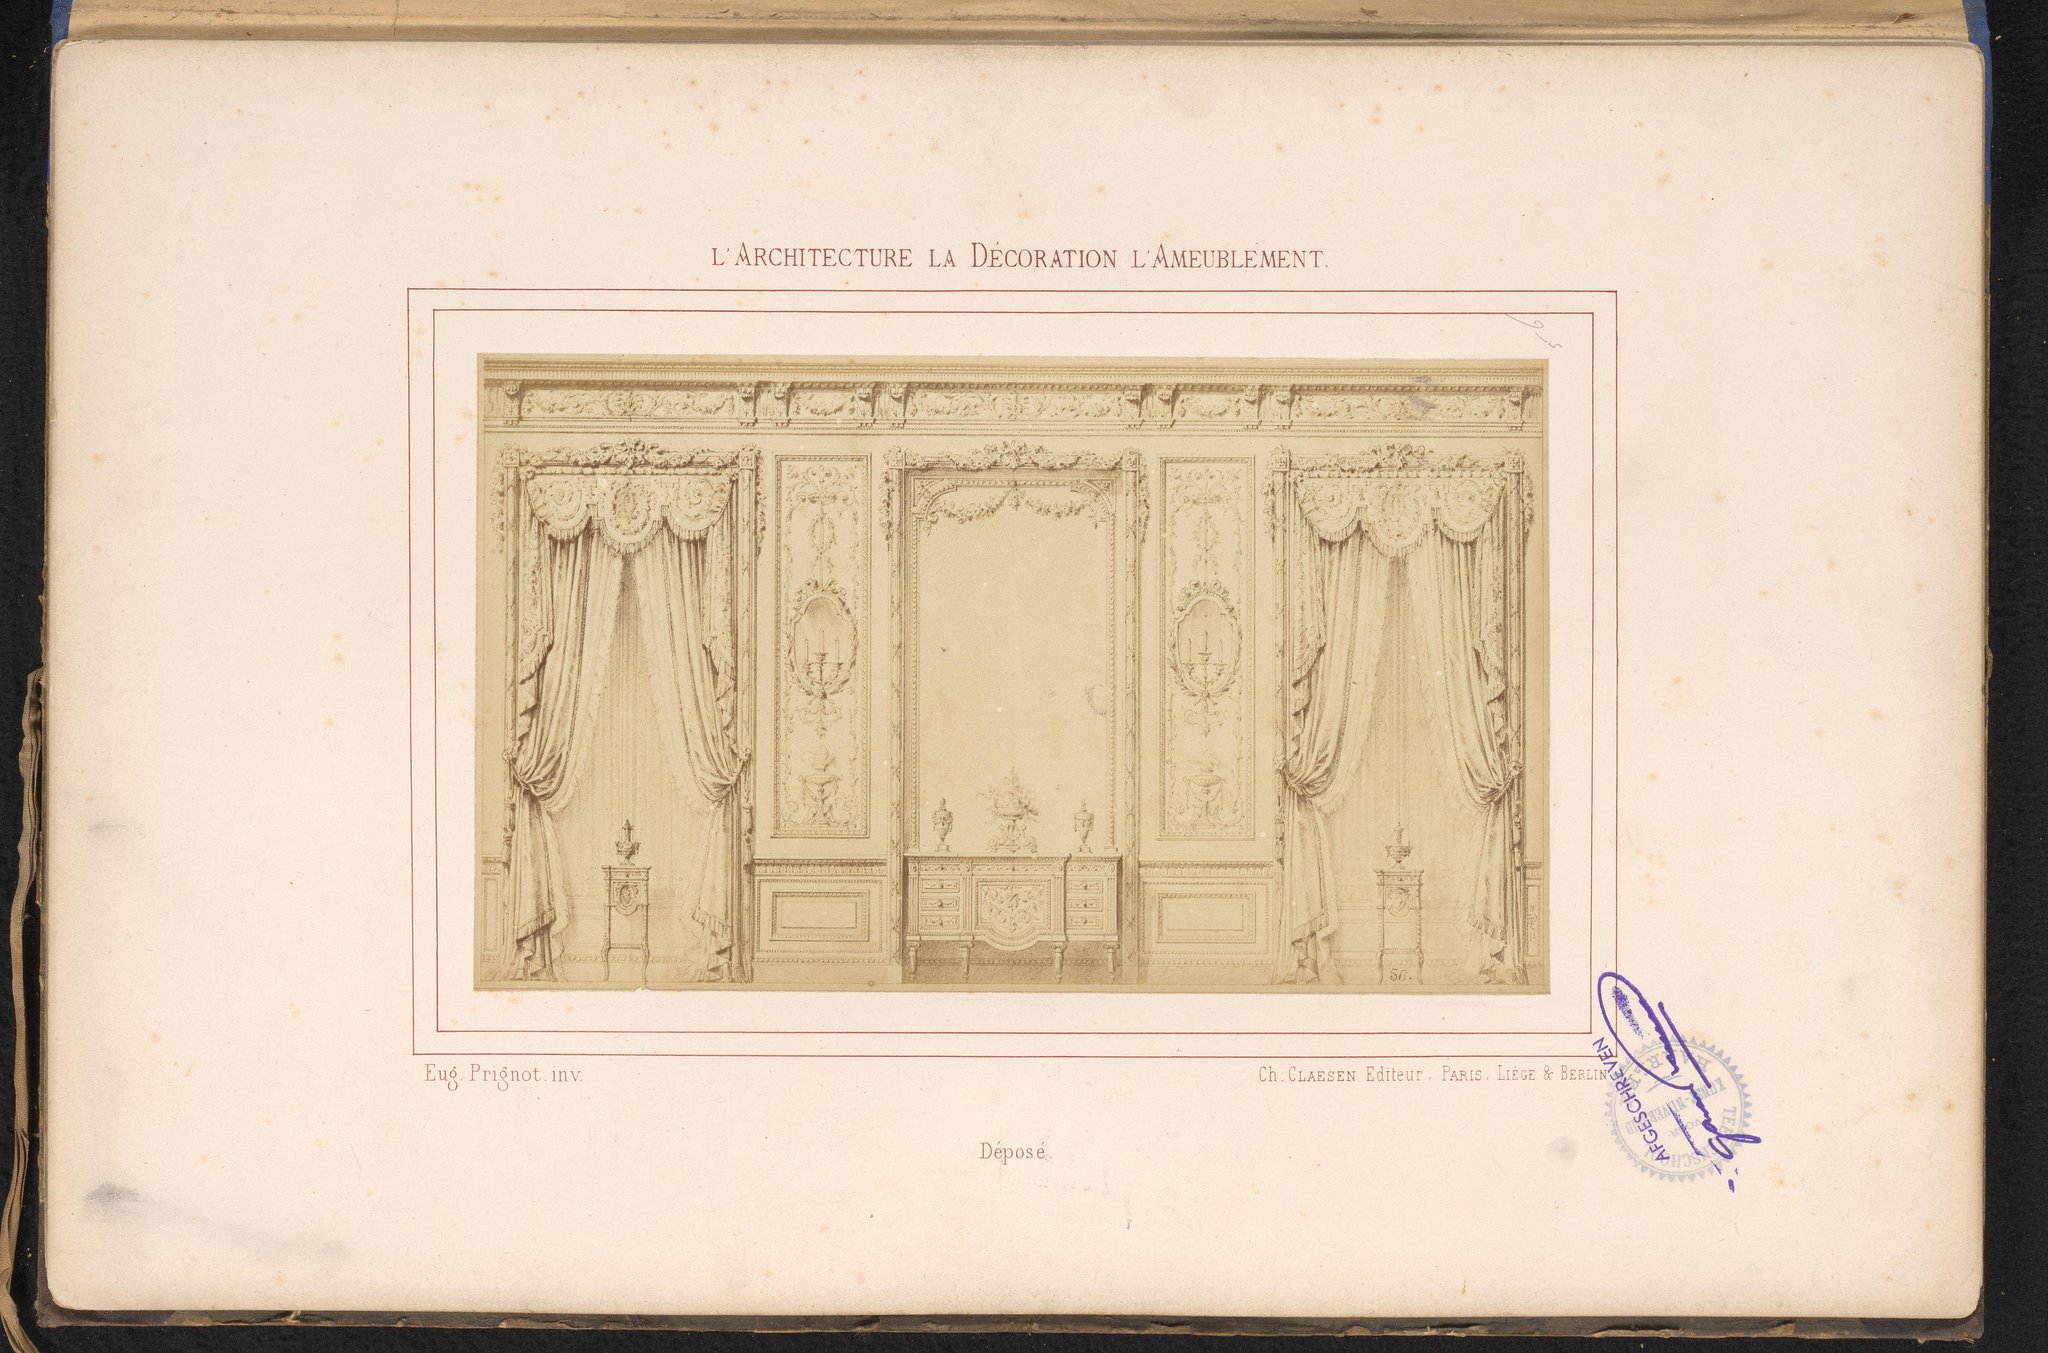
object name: reproduction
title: Fotoreproductie van een ontwerp voor een wandindeling met een spiegel, een dressoir en twee deuren naar Alexandre Eugène Prignot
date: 1873-1880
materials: cardboard, paper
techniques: albumen print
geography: liège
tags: curtains, ornamental cupboard, 'trionfi di tavola', 'pièces montées', mirror, chandelier, candelabrum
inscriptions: stamp: ‘TEEKENSCHOOL/ VOOR/ KUNST-NIJVERHEID/ HAARLEM’, number: ‘56’, inscription: ‘Déposé’, inscription: ‘Eug. Prignot. inv.’, stamp: ‘AFGESCHREVEN/ [...]’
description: Deze foto maakt deel uit van een omslag met 61 foto's op 61 bladen.